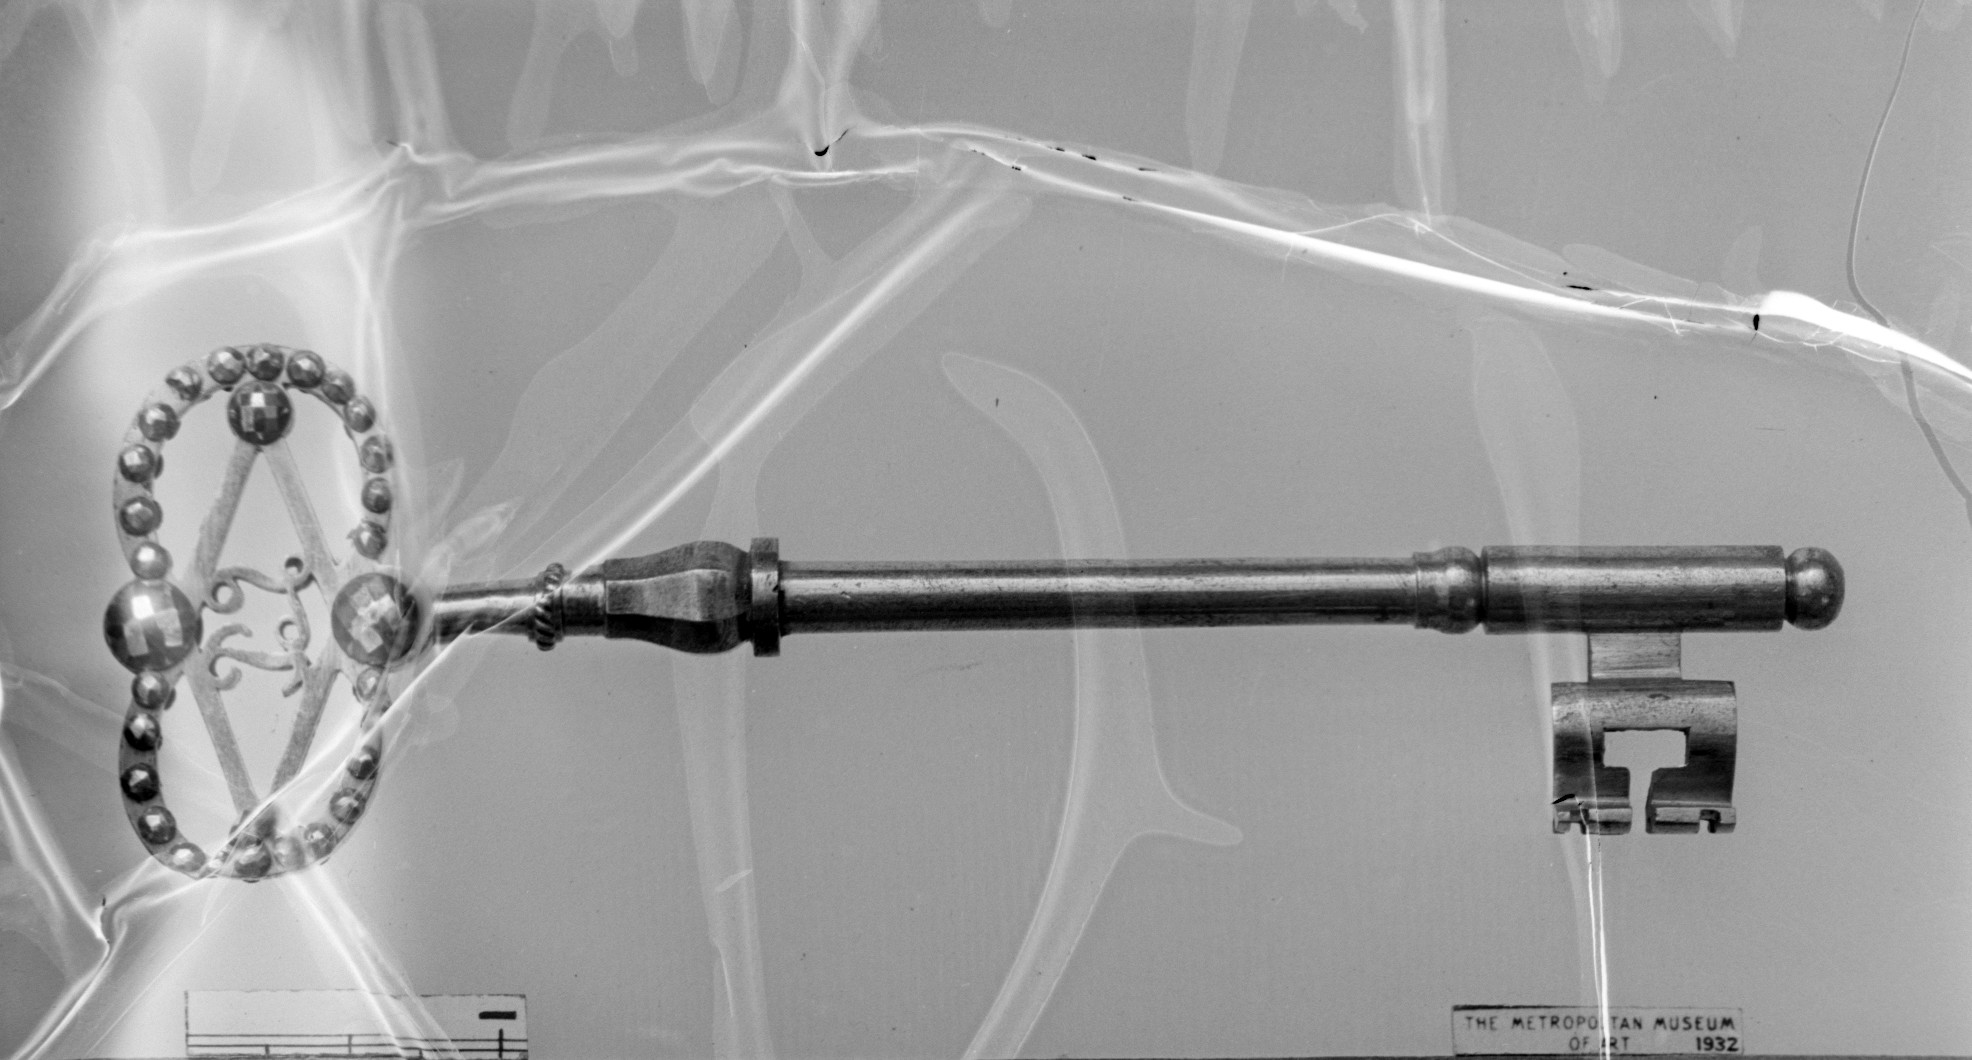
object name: key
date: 1701-1800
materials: steel